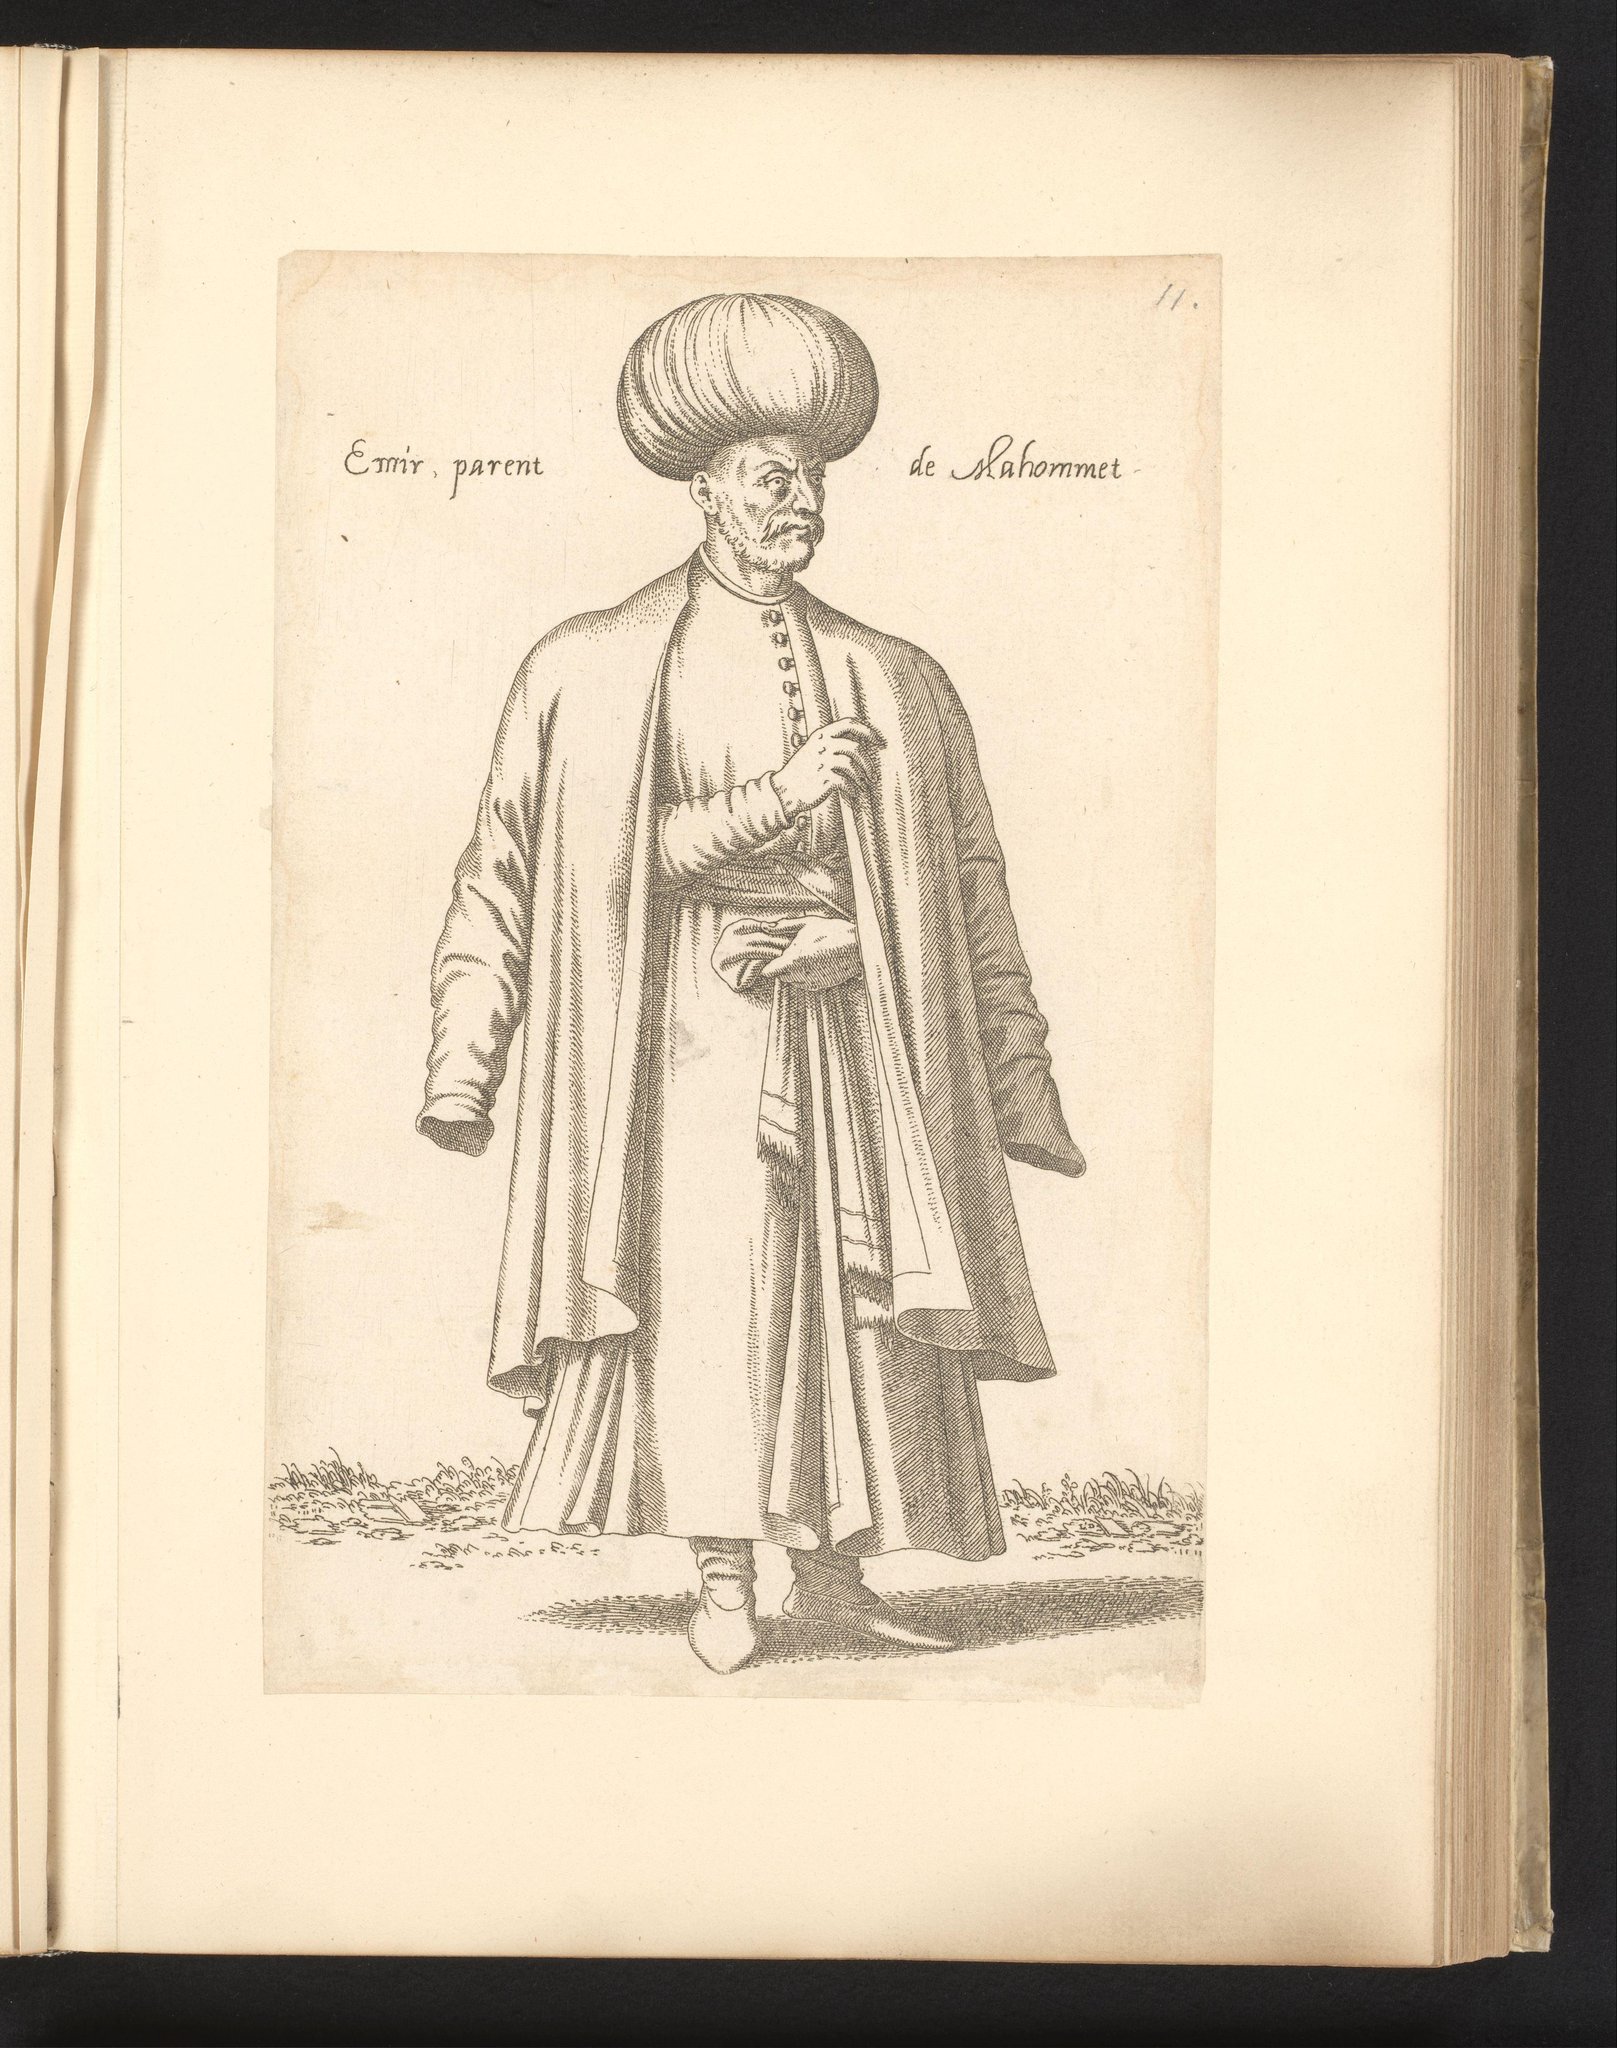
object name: print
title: Emir parent de Mahommet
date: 1555-1568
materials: paper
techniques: etching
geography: lyon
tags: africans (+ costume), asiatic races and peoples (+ costume), head-gear: turban, ranks ~ rulers, sovereigns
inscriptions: collector's mark: Lugt 2228, collector's mark: Lugt 2760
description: Prent uit: Nicolay, Nicolas de. Les quatre premiers livres des navigations et pérégrinations orientales, de N. de Nicolay, (...) Avec les figures au naturel tant d'hommes que de femmes selon la diversité des nations, & de leur port, maintien & habitz. Lyon: Guillaume (I) Rouille, 1568.